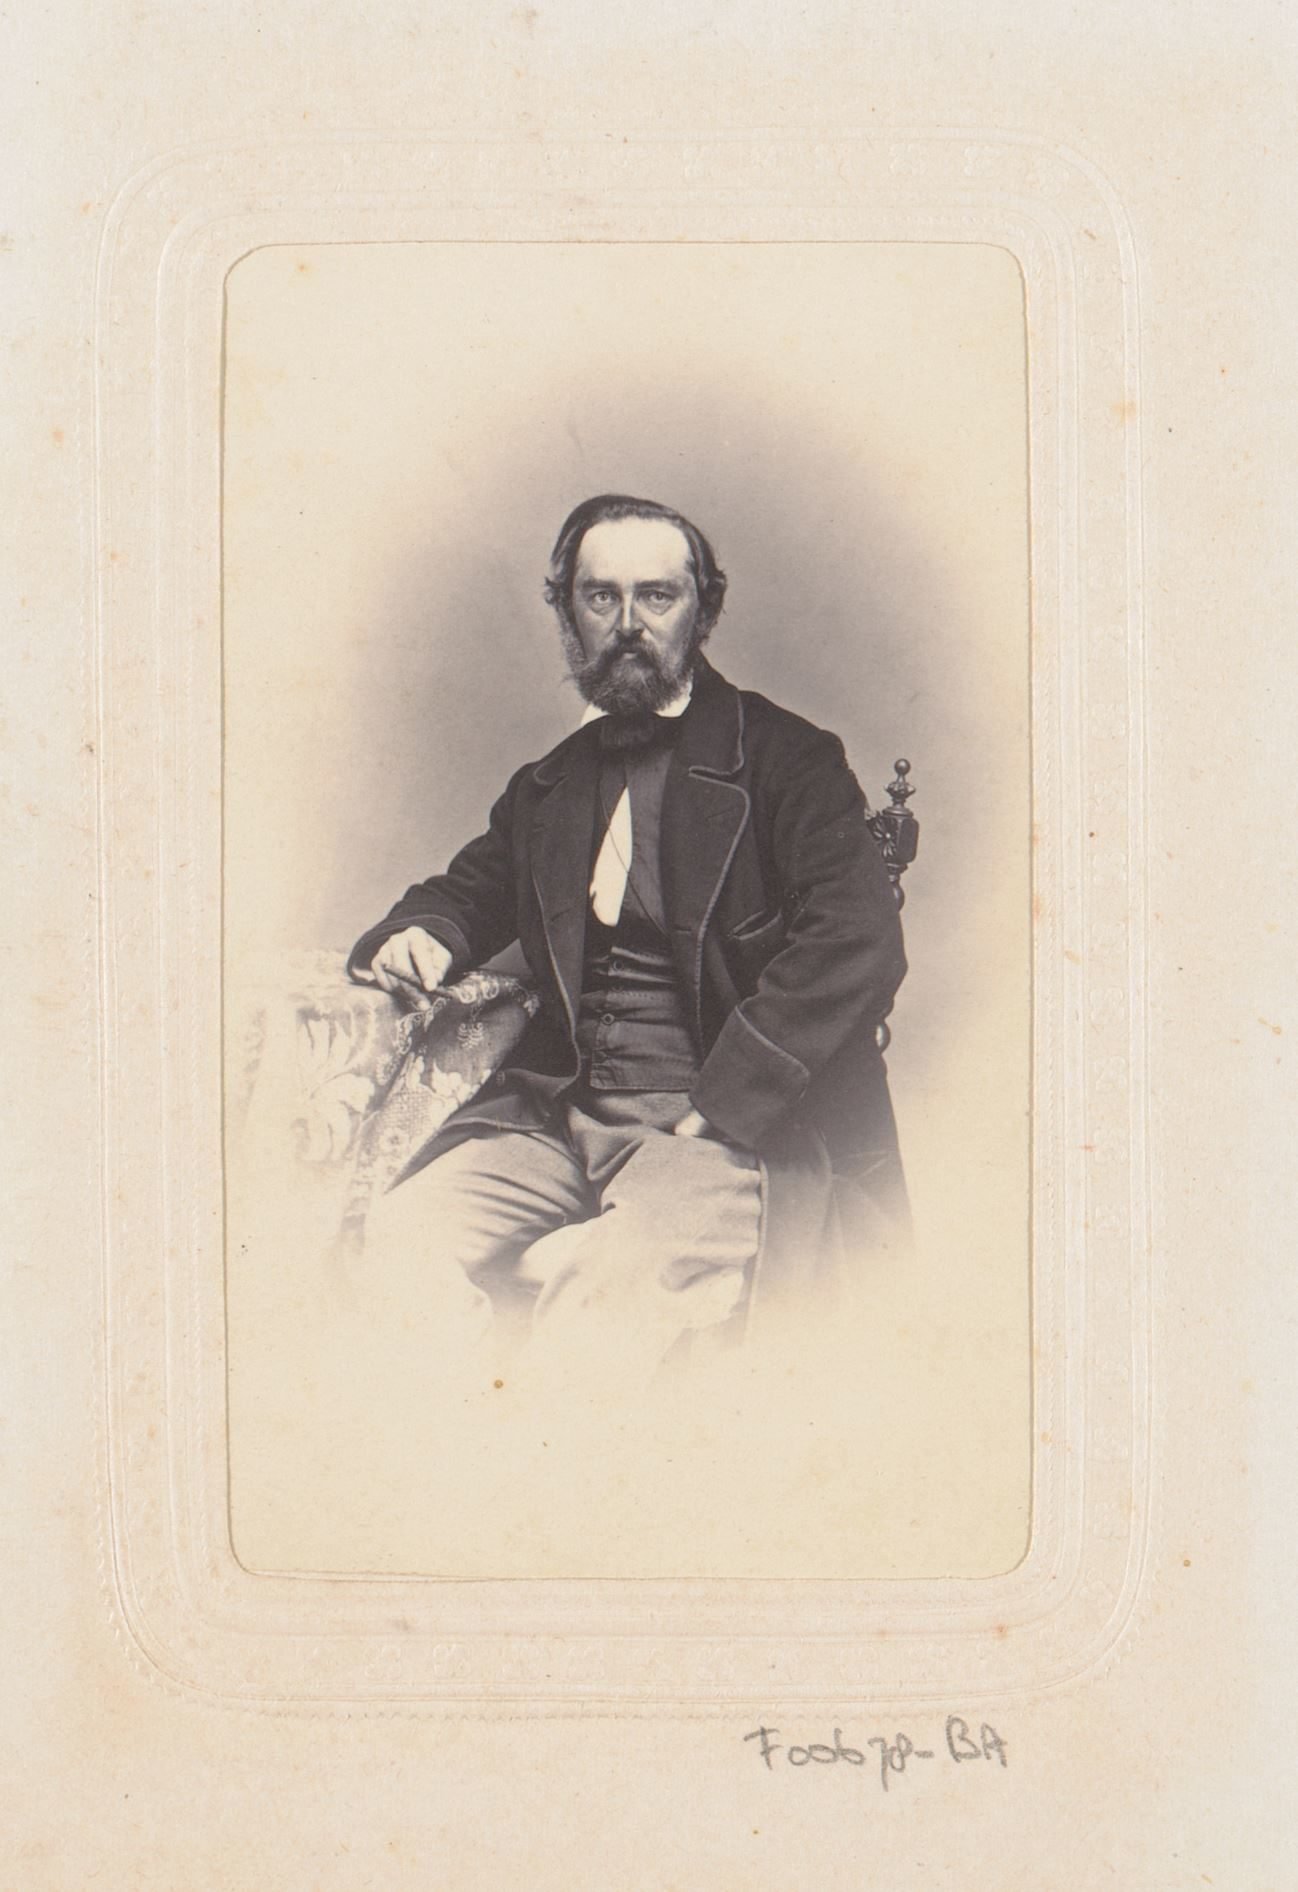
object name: carte de visite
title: Portret van een zittende man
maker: a. nissen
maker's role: fotograaf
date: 1860-1880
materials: cardboard, photographic support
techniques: albumen print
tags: sitting figure, historical persons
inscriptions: inscription: ‘A. Nissen/ Photograph in Deetzbüll’